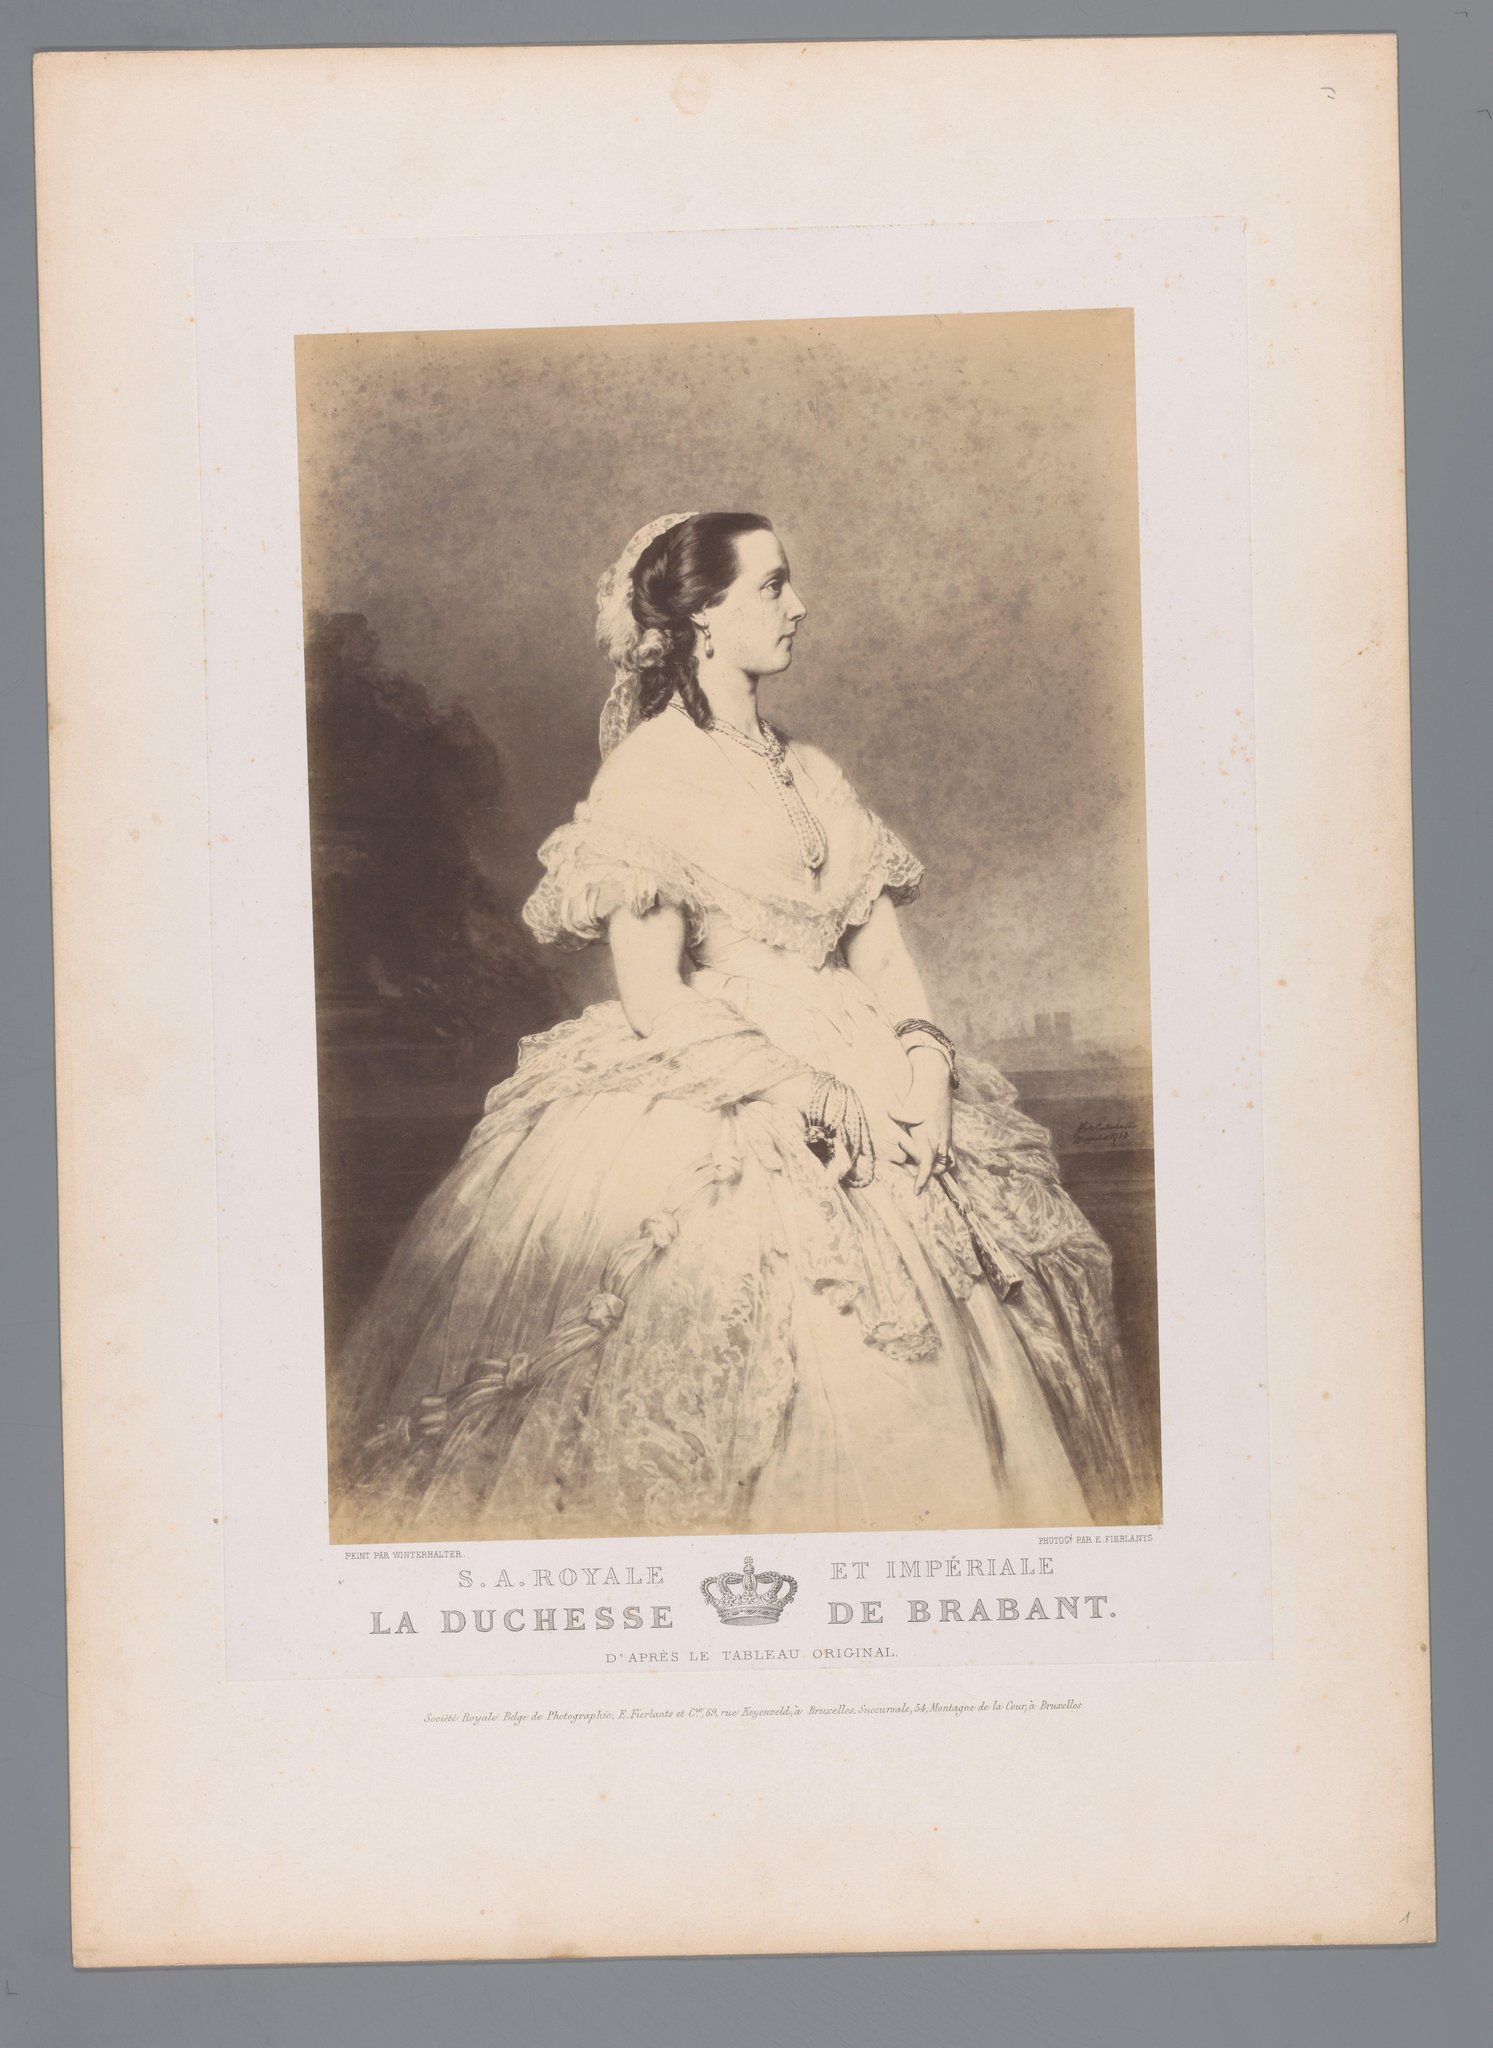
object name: photograph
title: S. A. Royale et Impériale la Duchesse de Brabant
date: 1858-1863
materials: photographic support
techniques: albumen print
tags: historical persons - bb - woman, queen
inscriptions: inscription: ‘Société Royal Belge de Photographie. E. Fierlants et Cie., 69, rue Keyenveld, à Bruxelles. Succursale, 54, Montagne de la Cour, à Bruxelles.’, number: ‘1’, inscription: ‘D'APRÈS LE TABLEAU ORIGINAL.’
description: Deze foto maakt deel uit van een omslag met zeven foto's, twee titelbladen en een lijst van afbeeldingen.